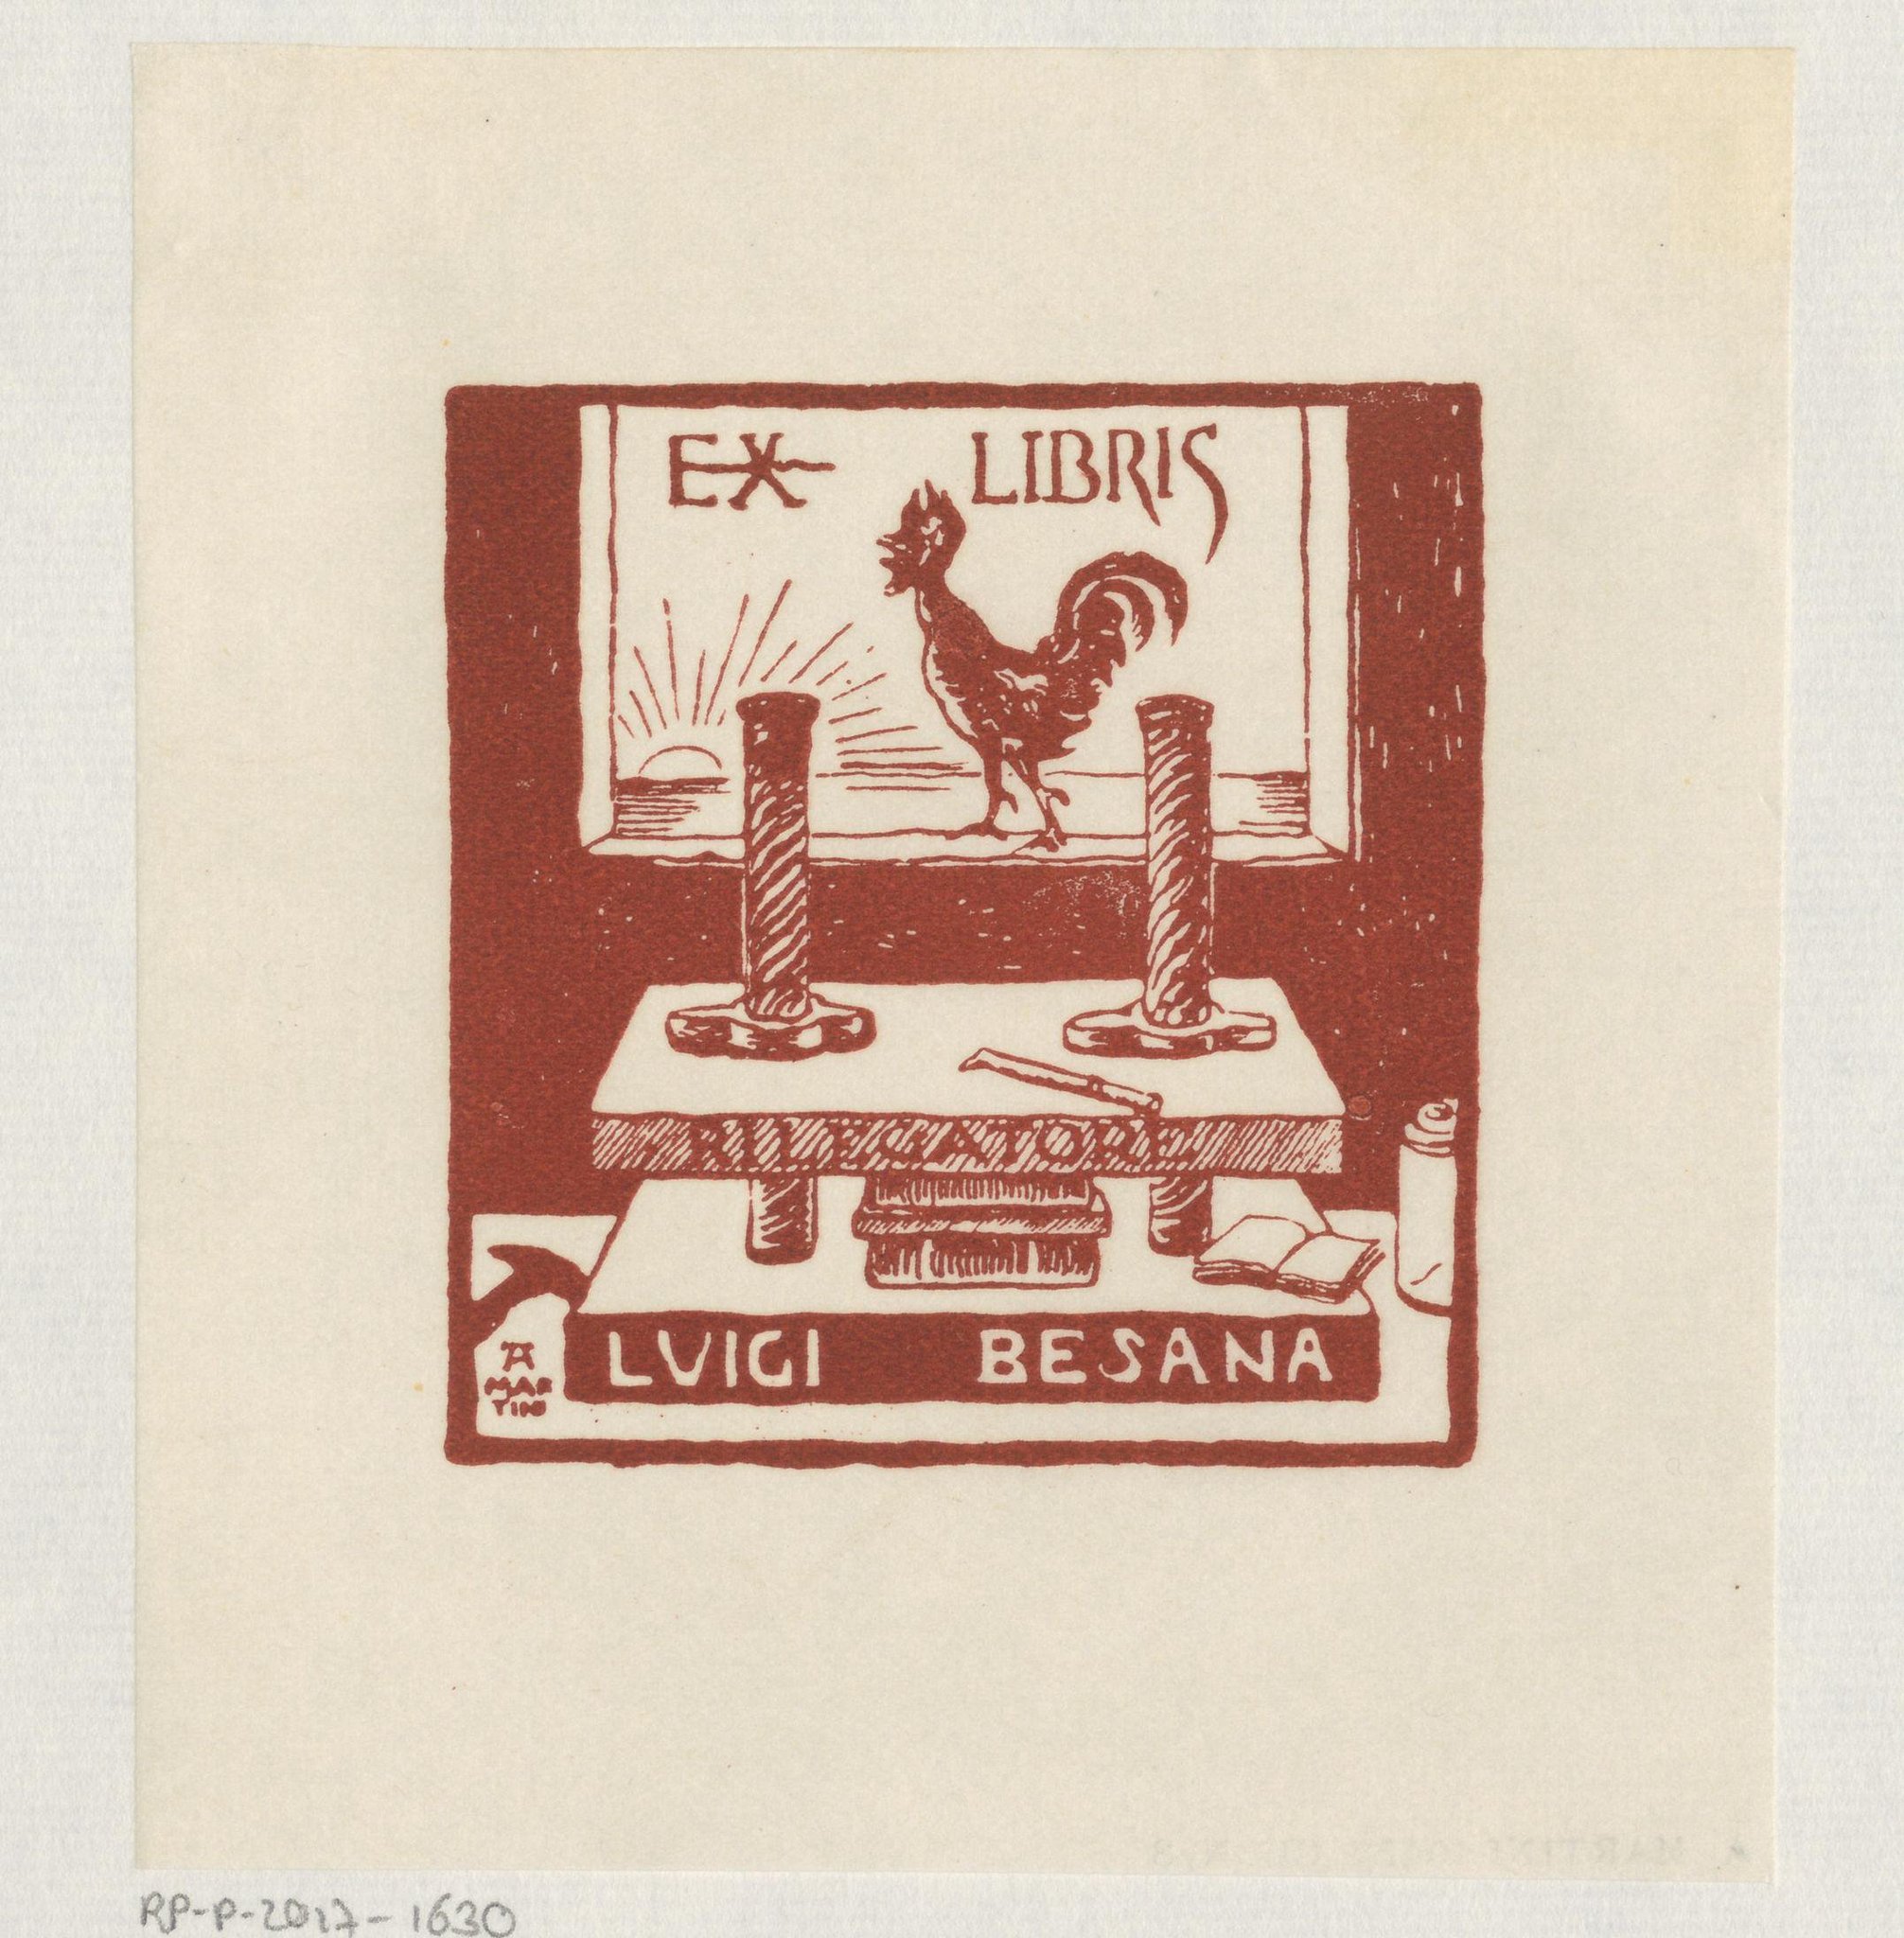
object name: bookplate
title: Ex libris van Luigi Besana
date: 1945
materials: paper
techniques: printing block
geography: italy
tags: bookbinding, book, sunrise, fowl (cock, hen, chicken, etc.)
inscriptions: workshop stamp: ‘A. Martini 1945. Cl.N. 8’